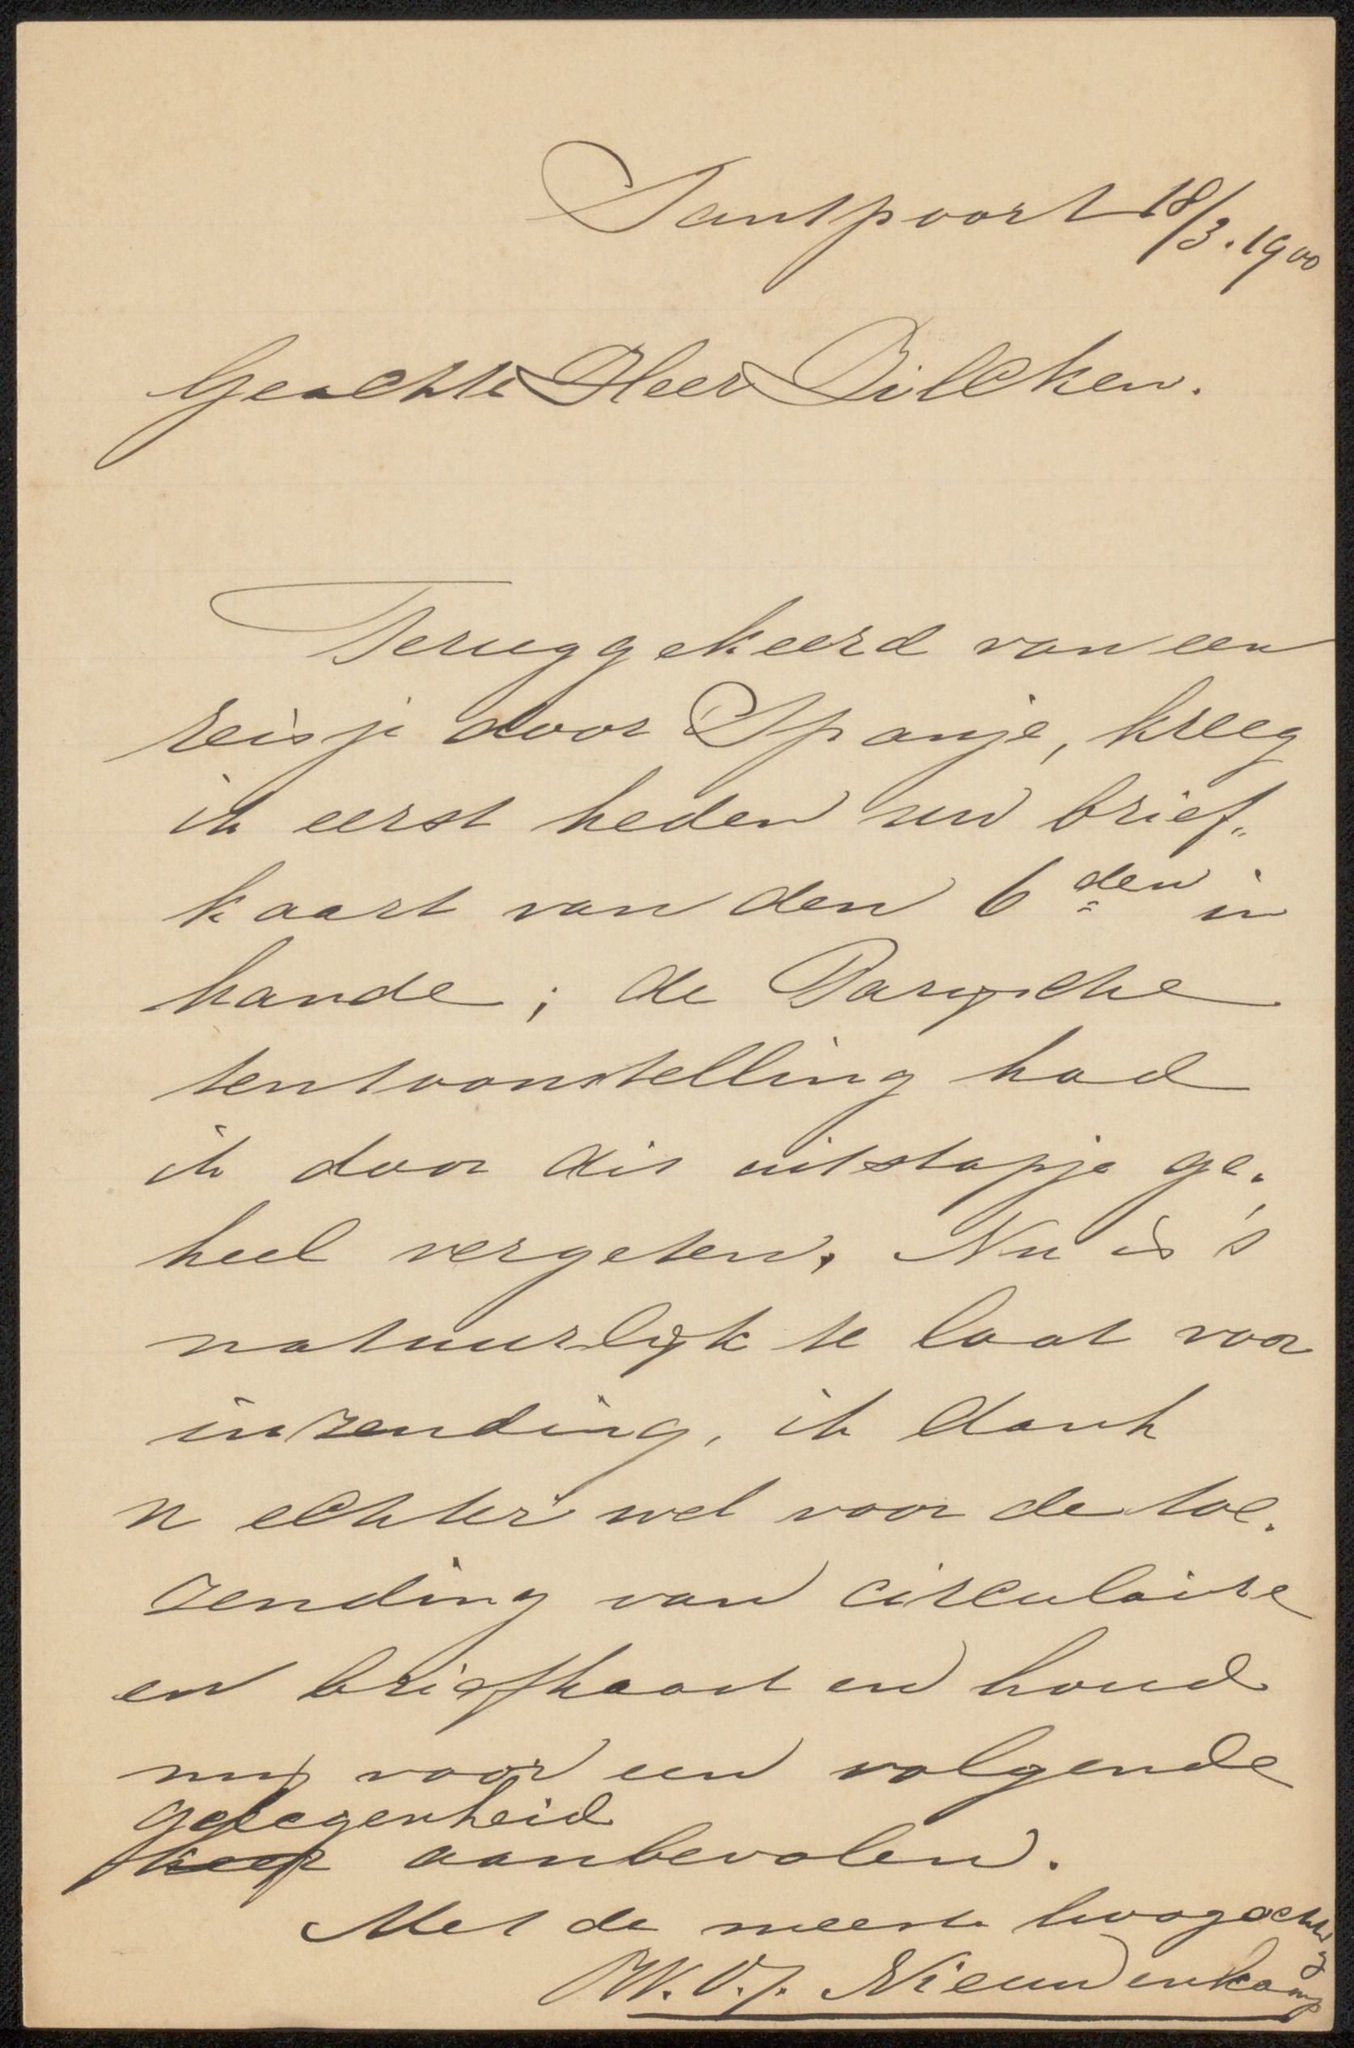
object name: letter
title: Brief aan Philip Zilcken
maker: wijnand otto jan nieuwenkamp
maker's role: draughtsman, print maker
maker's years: 1874-1950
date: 1900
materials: ink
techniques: pen, writing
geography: santpoort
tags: painter, draughtsman, philip zilcken, exhibition ~ art, paris, spain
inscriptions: collector's mark: ‘RPK’